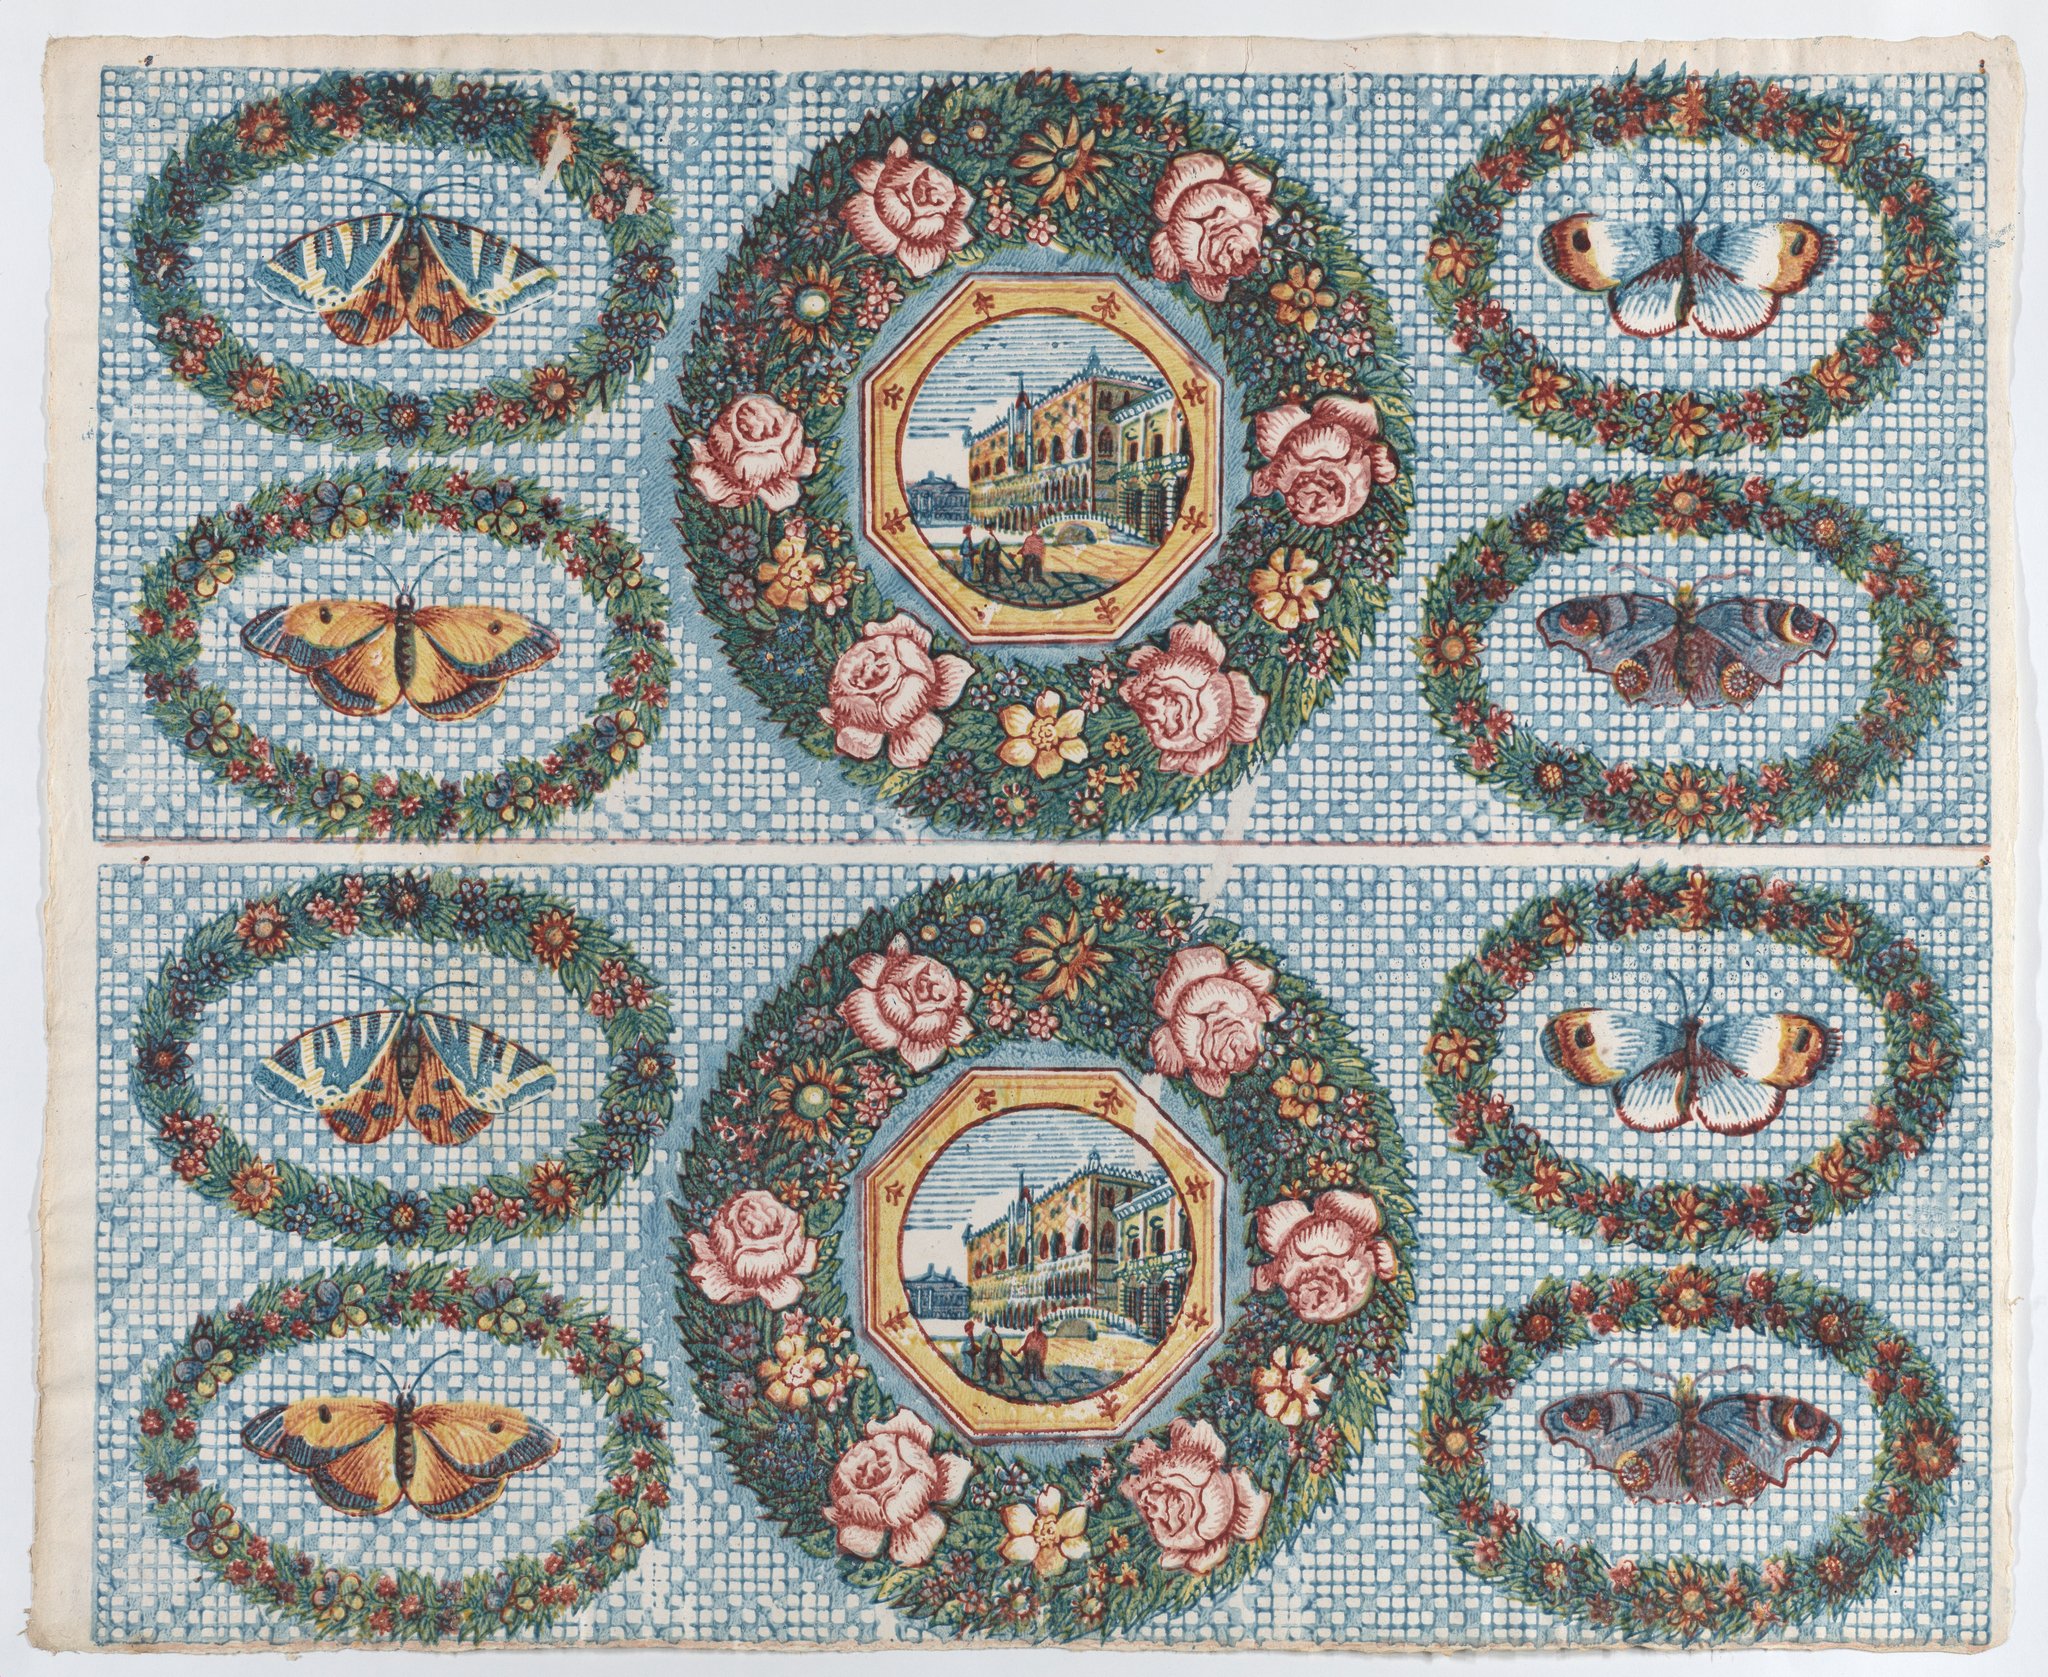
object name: print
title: Sheet with two borders with landscapes and moths within wreaths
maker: Anonymous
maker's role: artist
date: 1767-1866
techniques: relief print